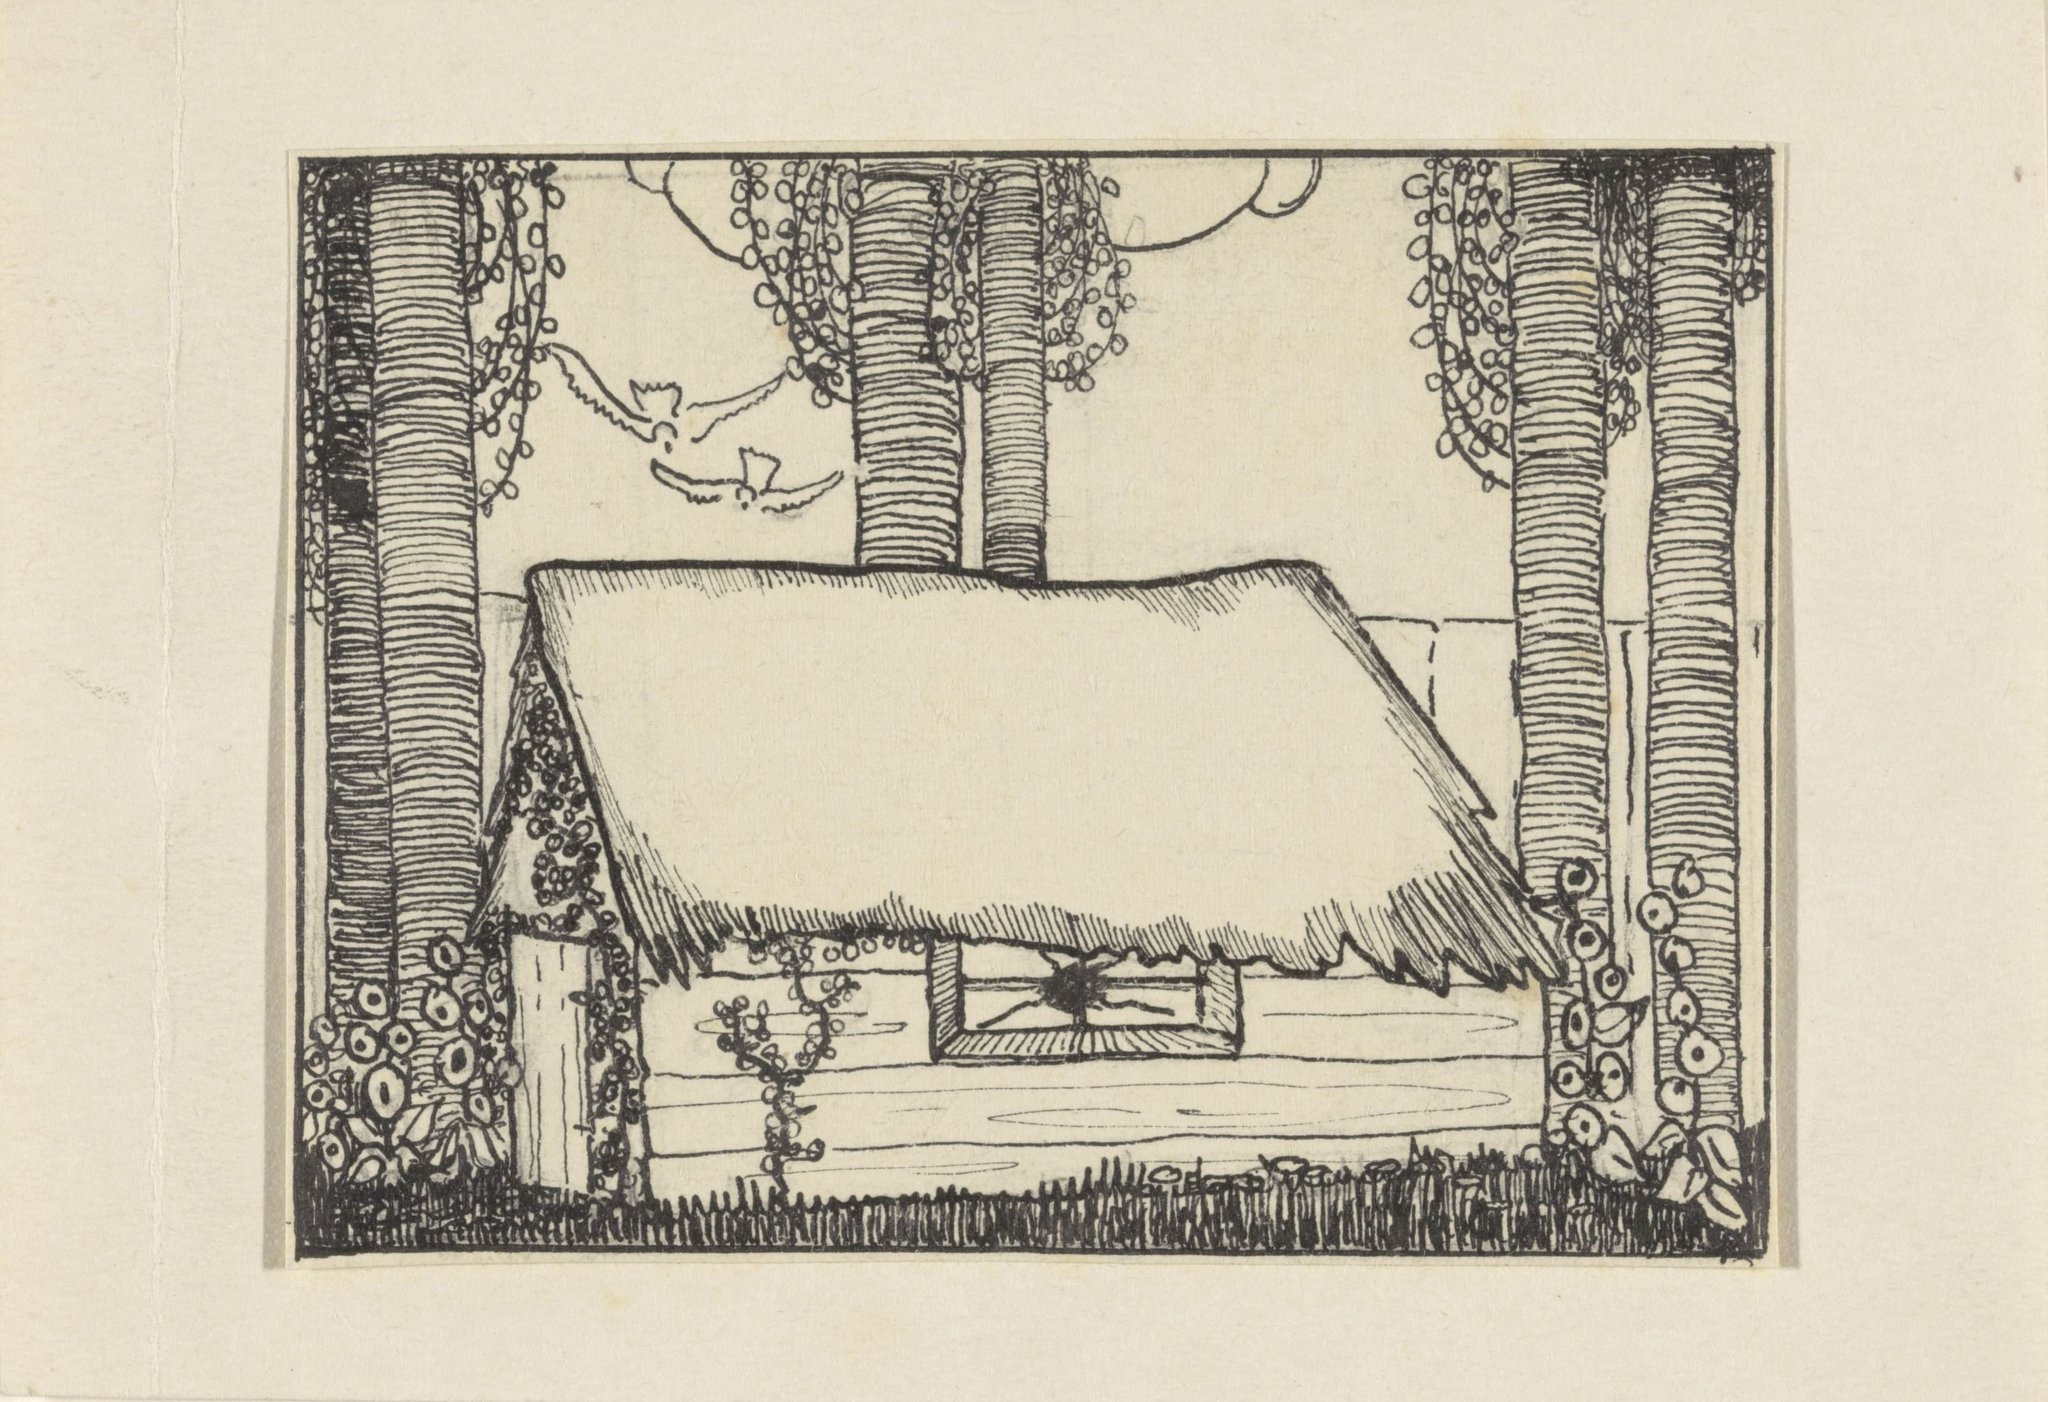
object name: boekillustratie ontwerp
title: Schuur of hut met rieten dak tussen de bomen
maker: c. goes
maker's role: draughtsman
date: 1900-1940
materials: ink, paper, pencil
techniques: pen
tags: barn, trees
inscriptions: signature: ‘CLAERGOES’, collector's mark: Lugt 2228a, :